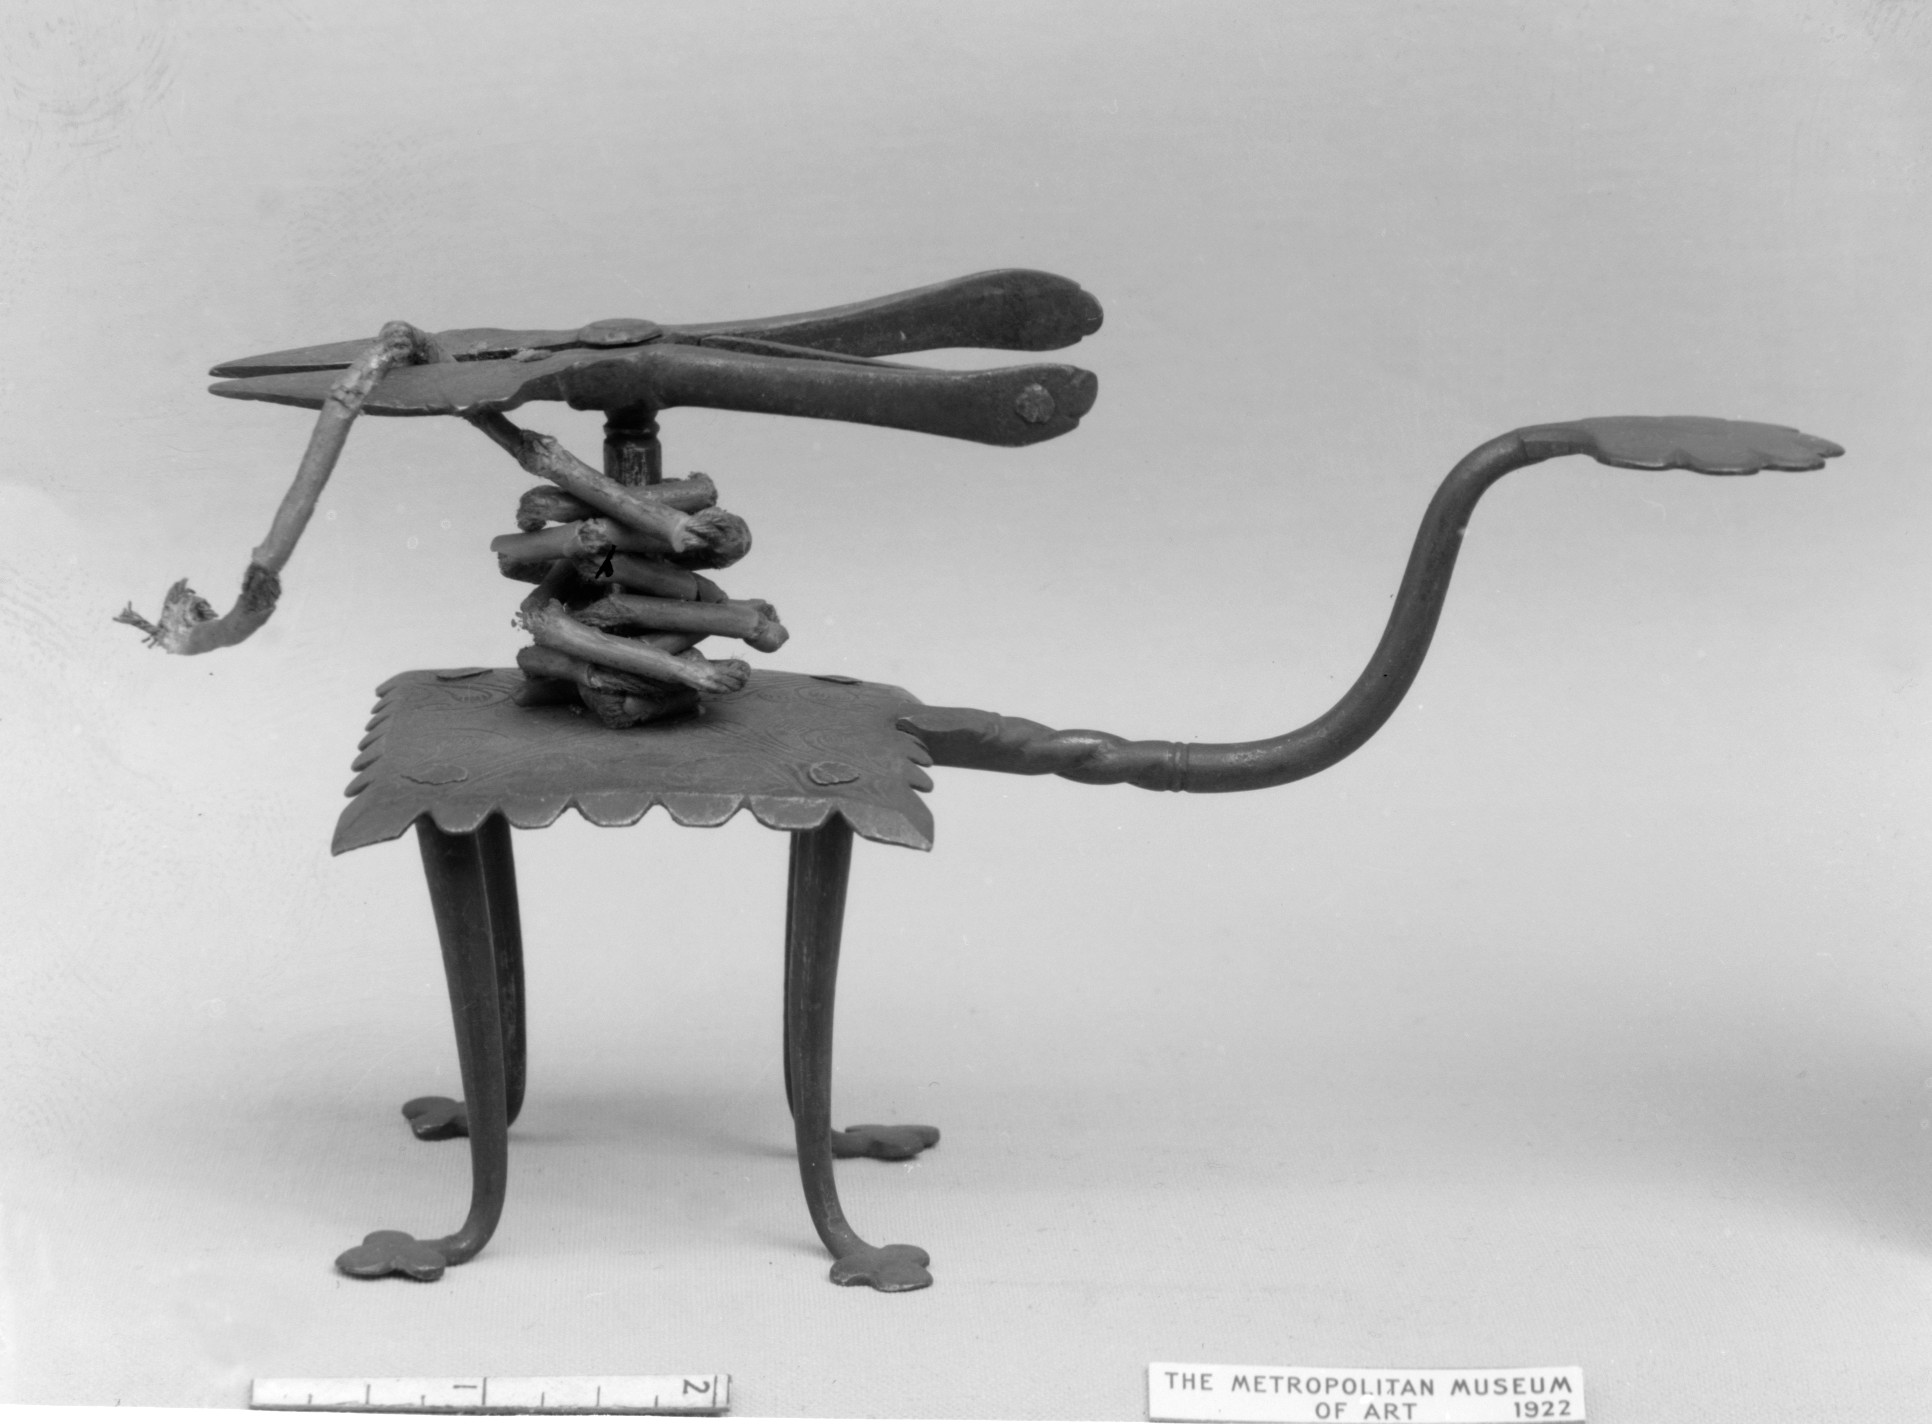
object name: taper holder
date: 1601-1700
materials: iron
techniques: hammering